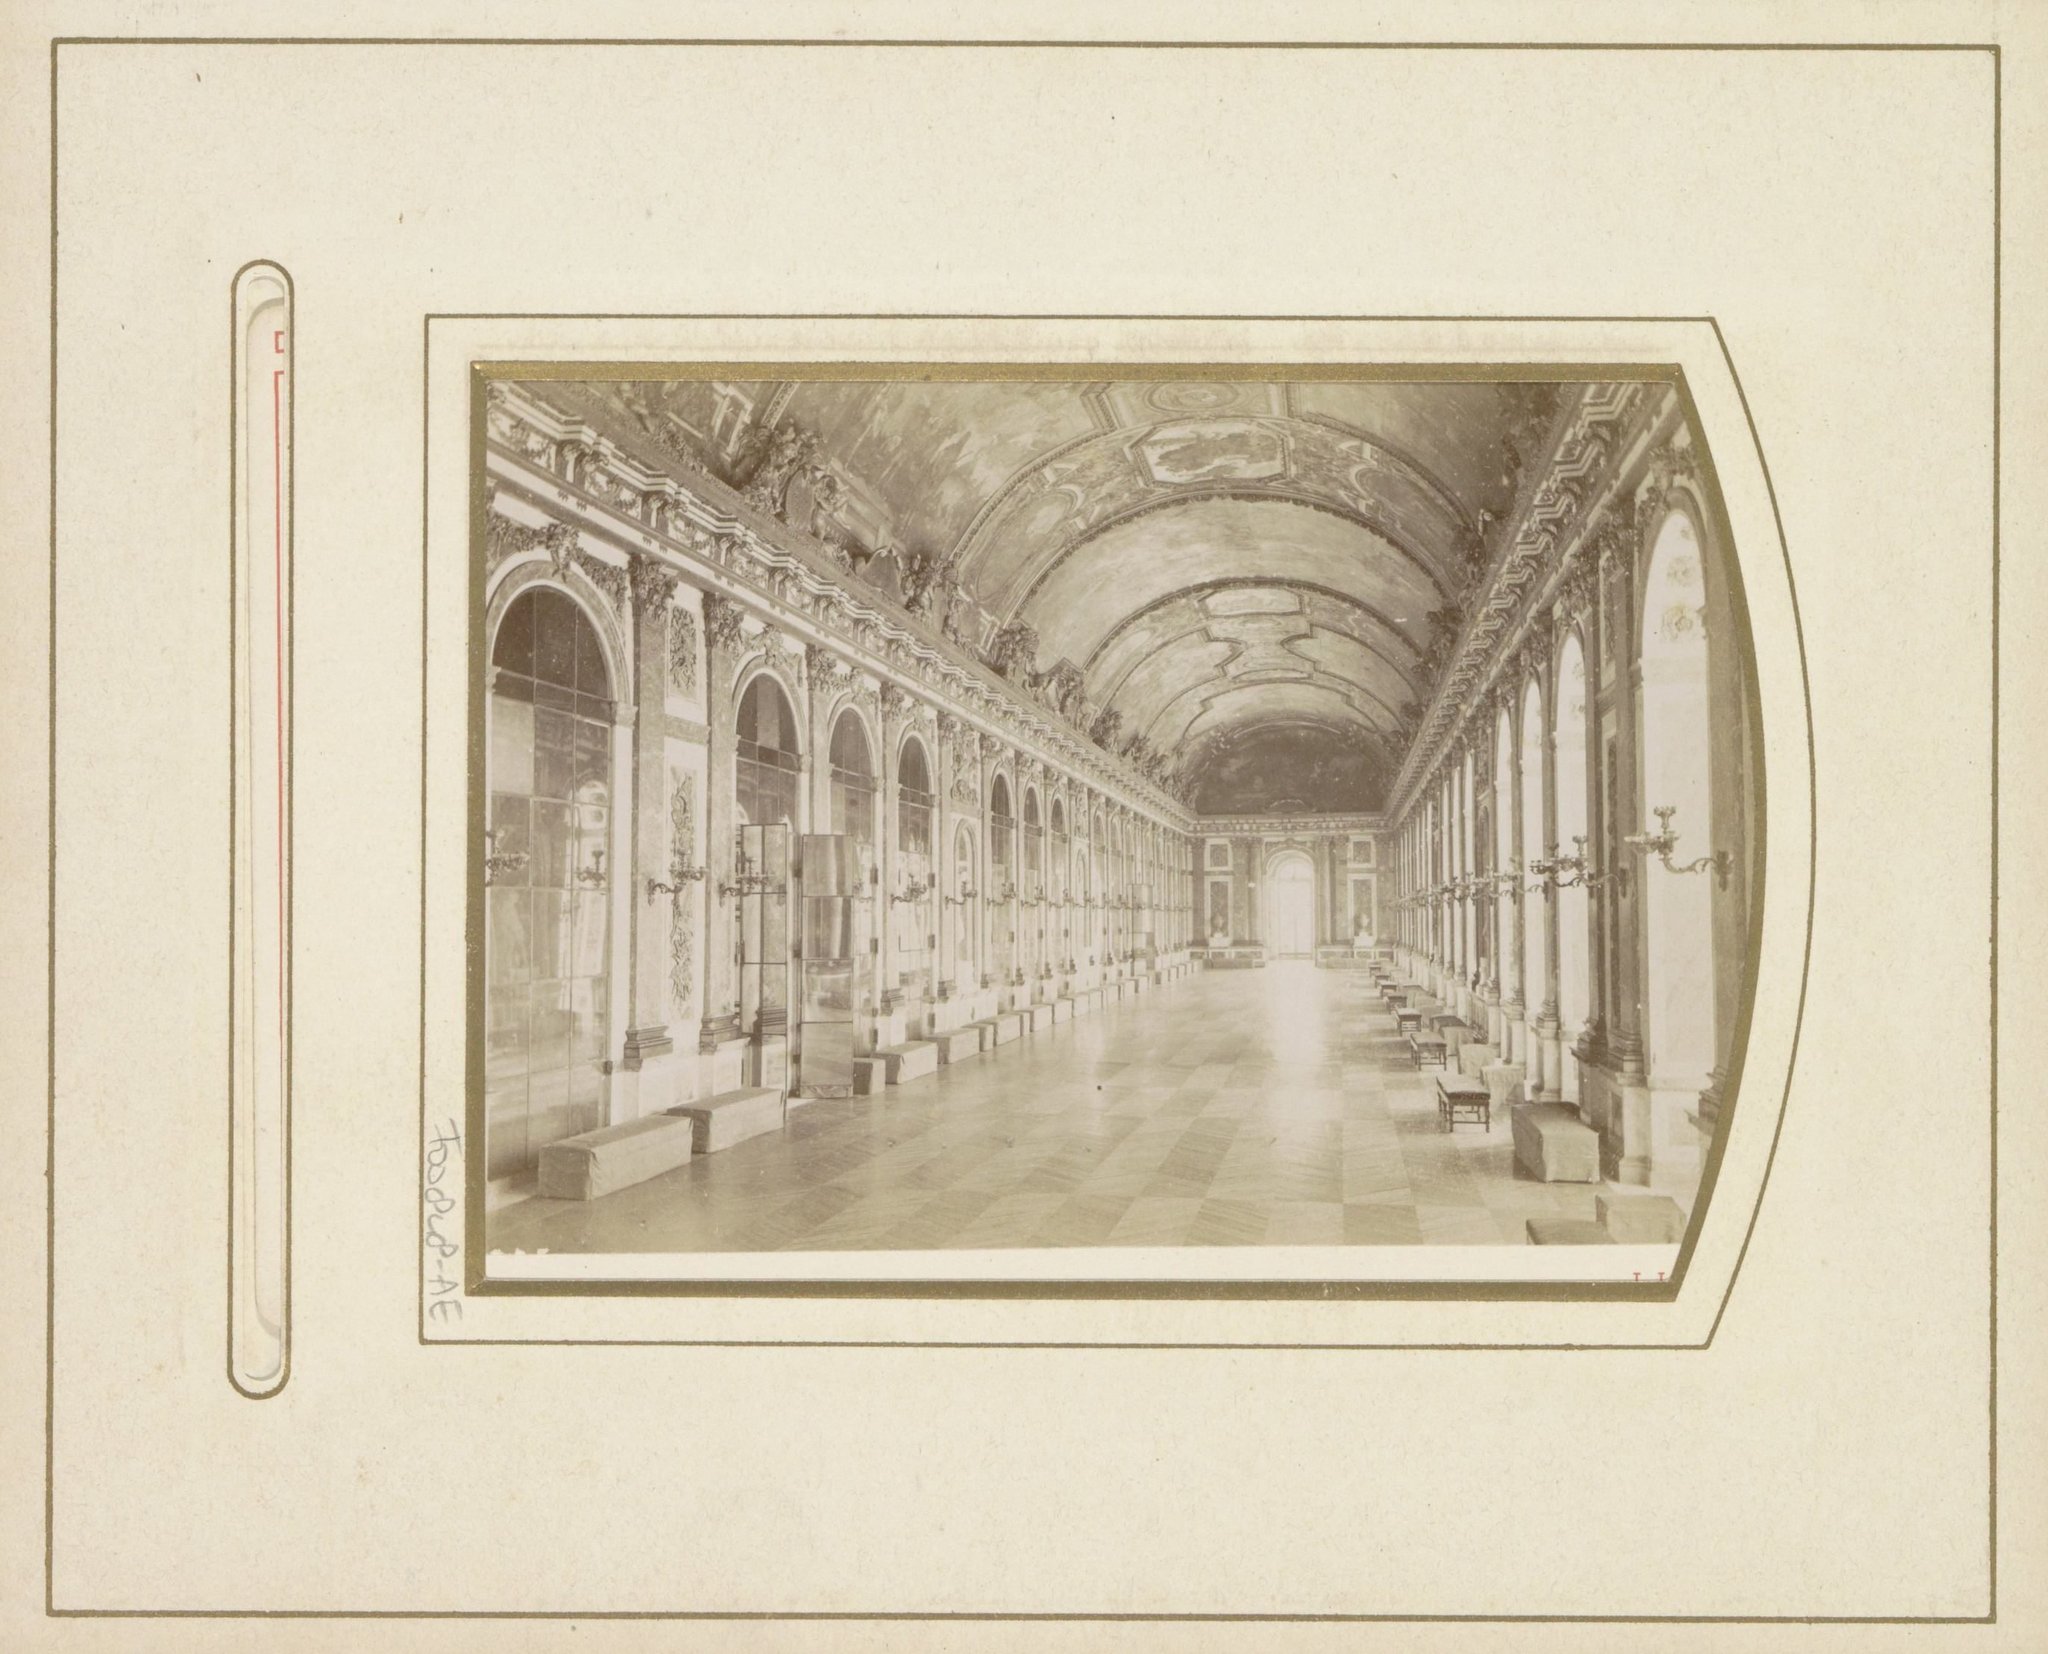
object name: cabinet photograph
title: Galerie des Glaces. Versailles.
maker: ll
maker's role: fotograaf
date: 1870-1900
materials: cardboard, paper, photographic support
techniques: albumen print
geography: versailles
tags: palace, paris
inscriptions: inscription: ‘Maison Martinet Albert Hautecoeur 12, Bd des Capucines’, number: ‘15.’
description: Onderdeel van Fotoalbum met kabinetfoto's van bezienswaardigheden in Parijs en Versailles.